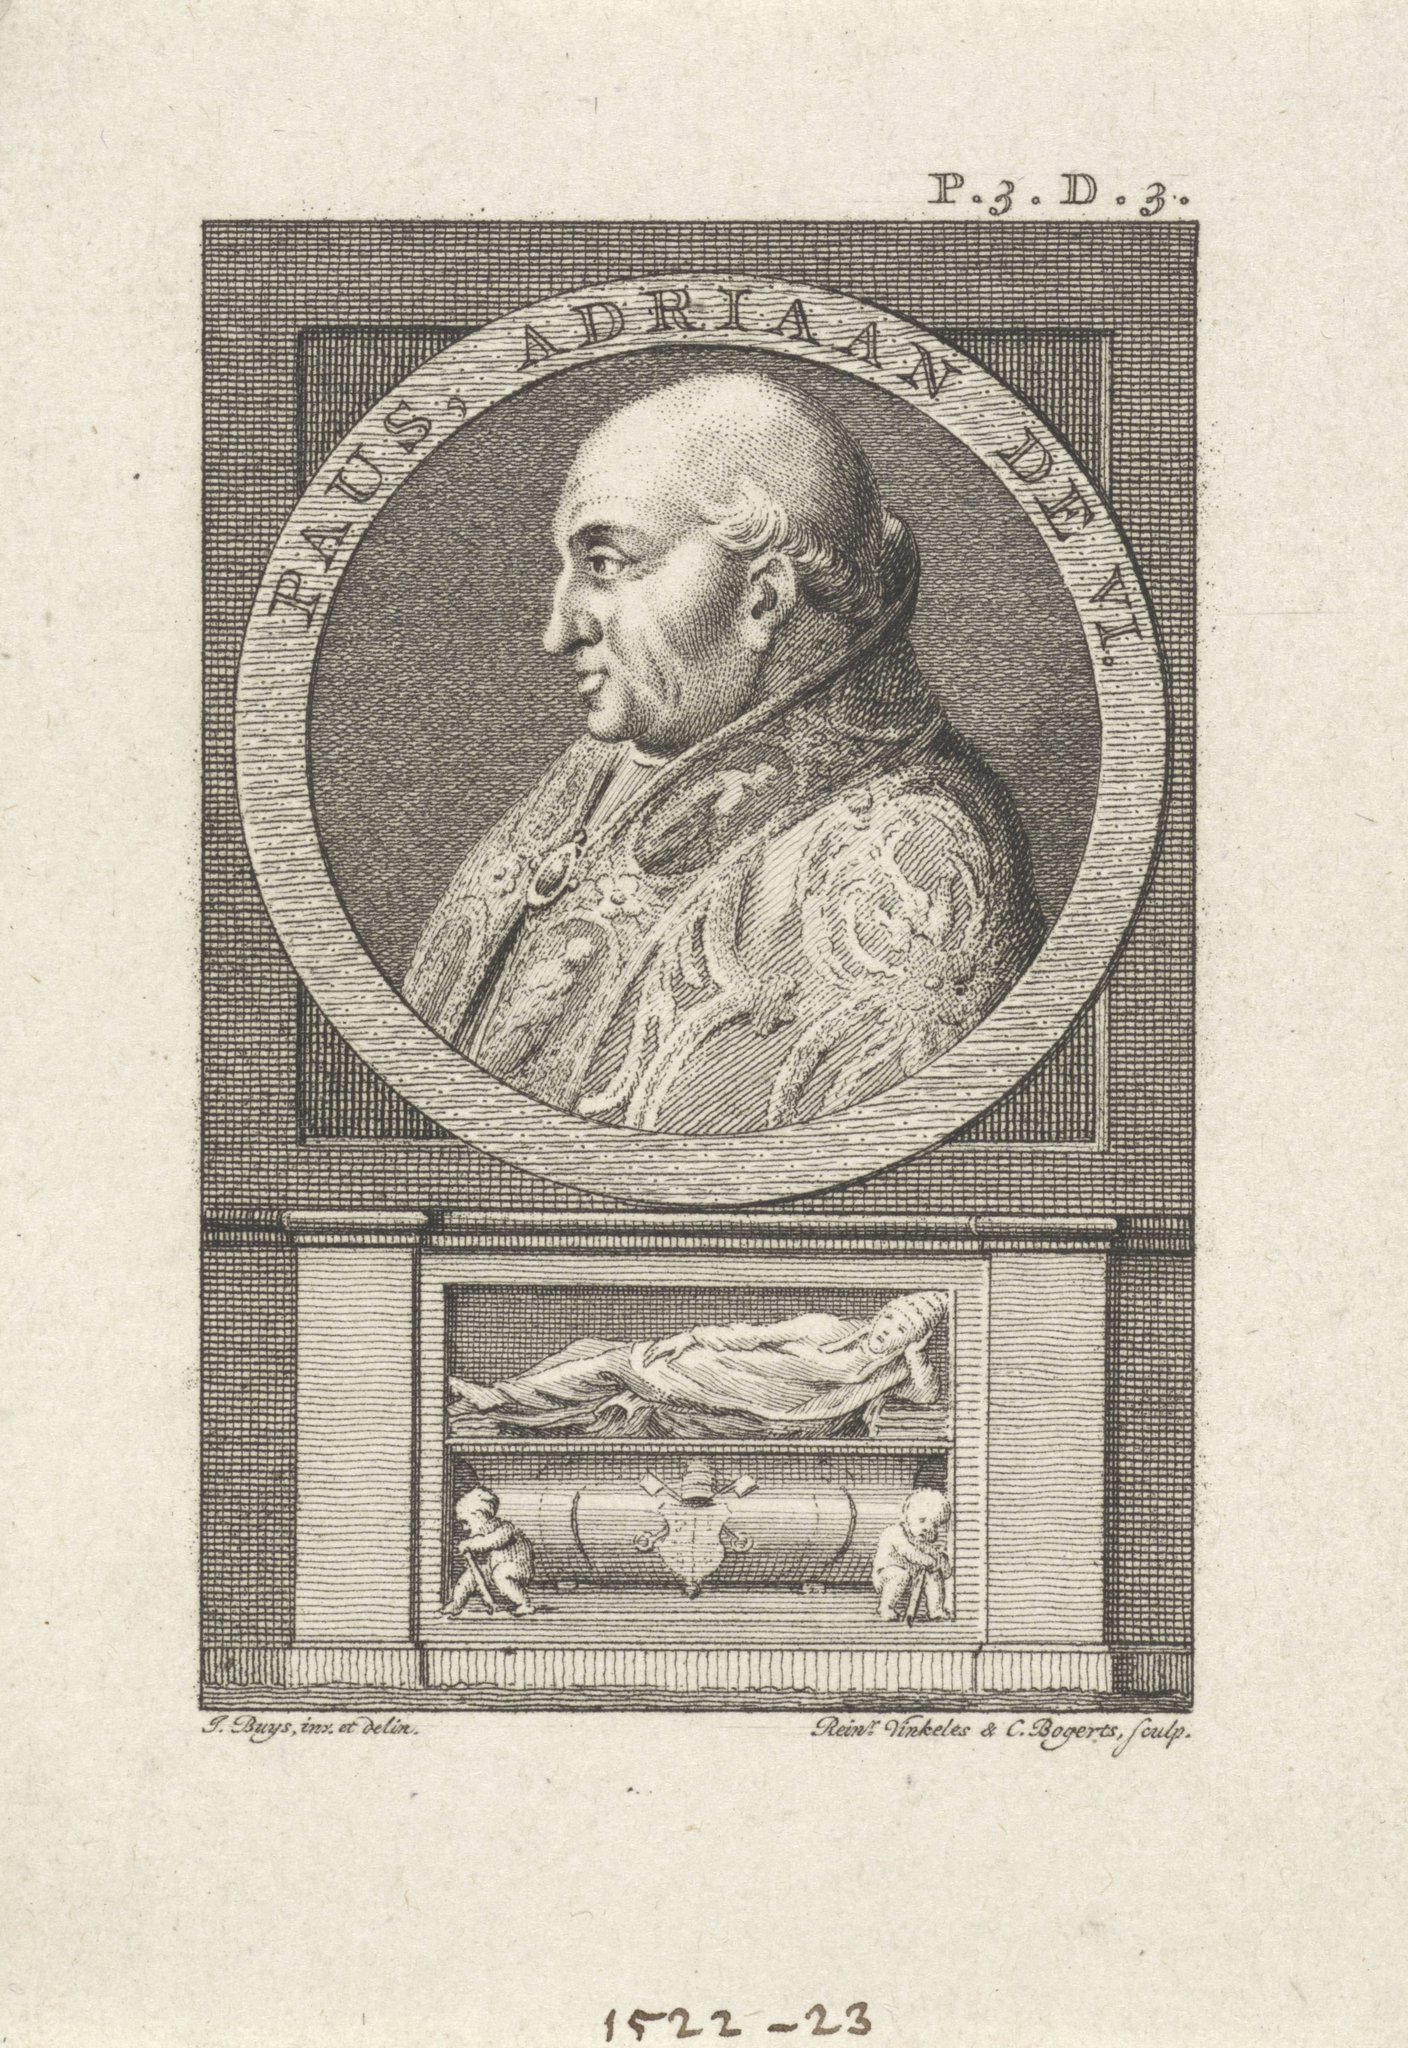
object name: print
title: Portret van paus Adrianus VI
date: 1783-1795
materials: paper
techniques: etching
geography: amsterdam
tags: rome, grave, tomb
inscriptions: collector's mark: Lugt 2228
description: Prent gebruikt in: Fokke, Jan. Geschiedenissen der Vereenigde Nederlanden voor de vaderlandsche jeugd Ie-XXVste deel. Amsterdam: Johannes Allart, 1783-1795. Deel III.